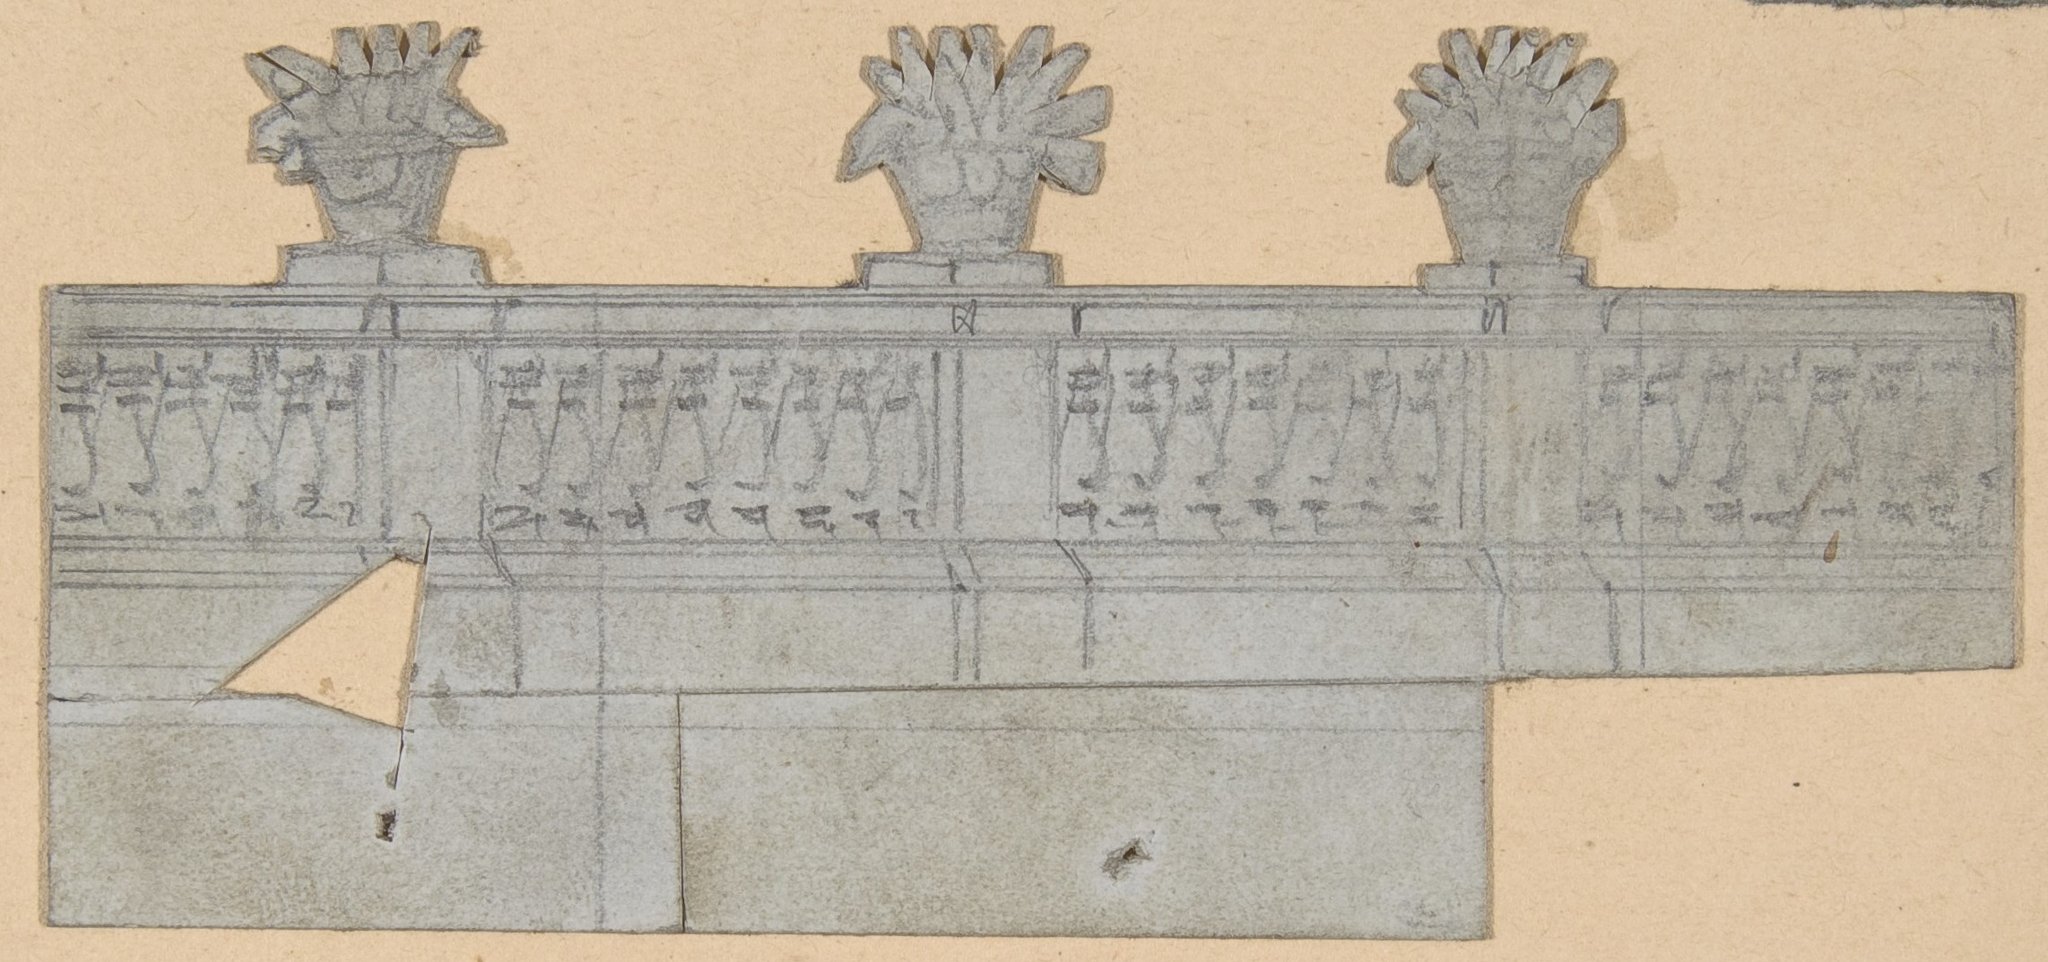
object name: drawing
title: Design for a Stage Set at the Opéra, Paris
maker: eugène cicéri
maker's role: artist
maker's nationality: french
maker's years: 1813-1890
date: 1830-1890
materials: graphite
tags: stage design